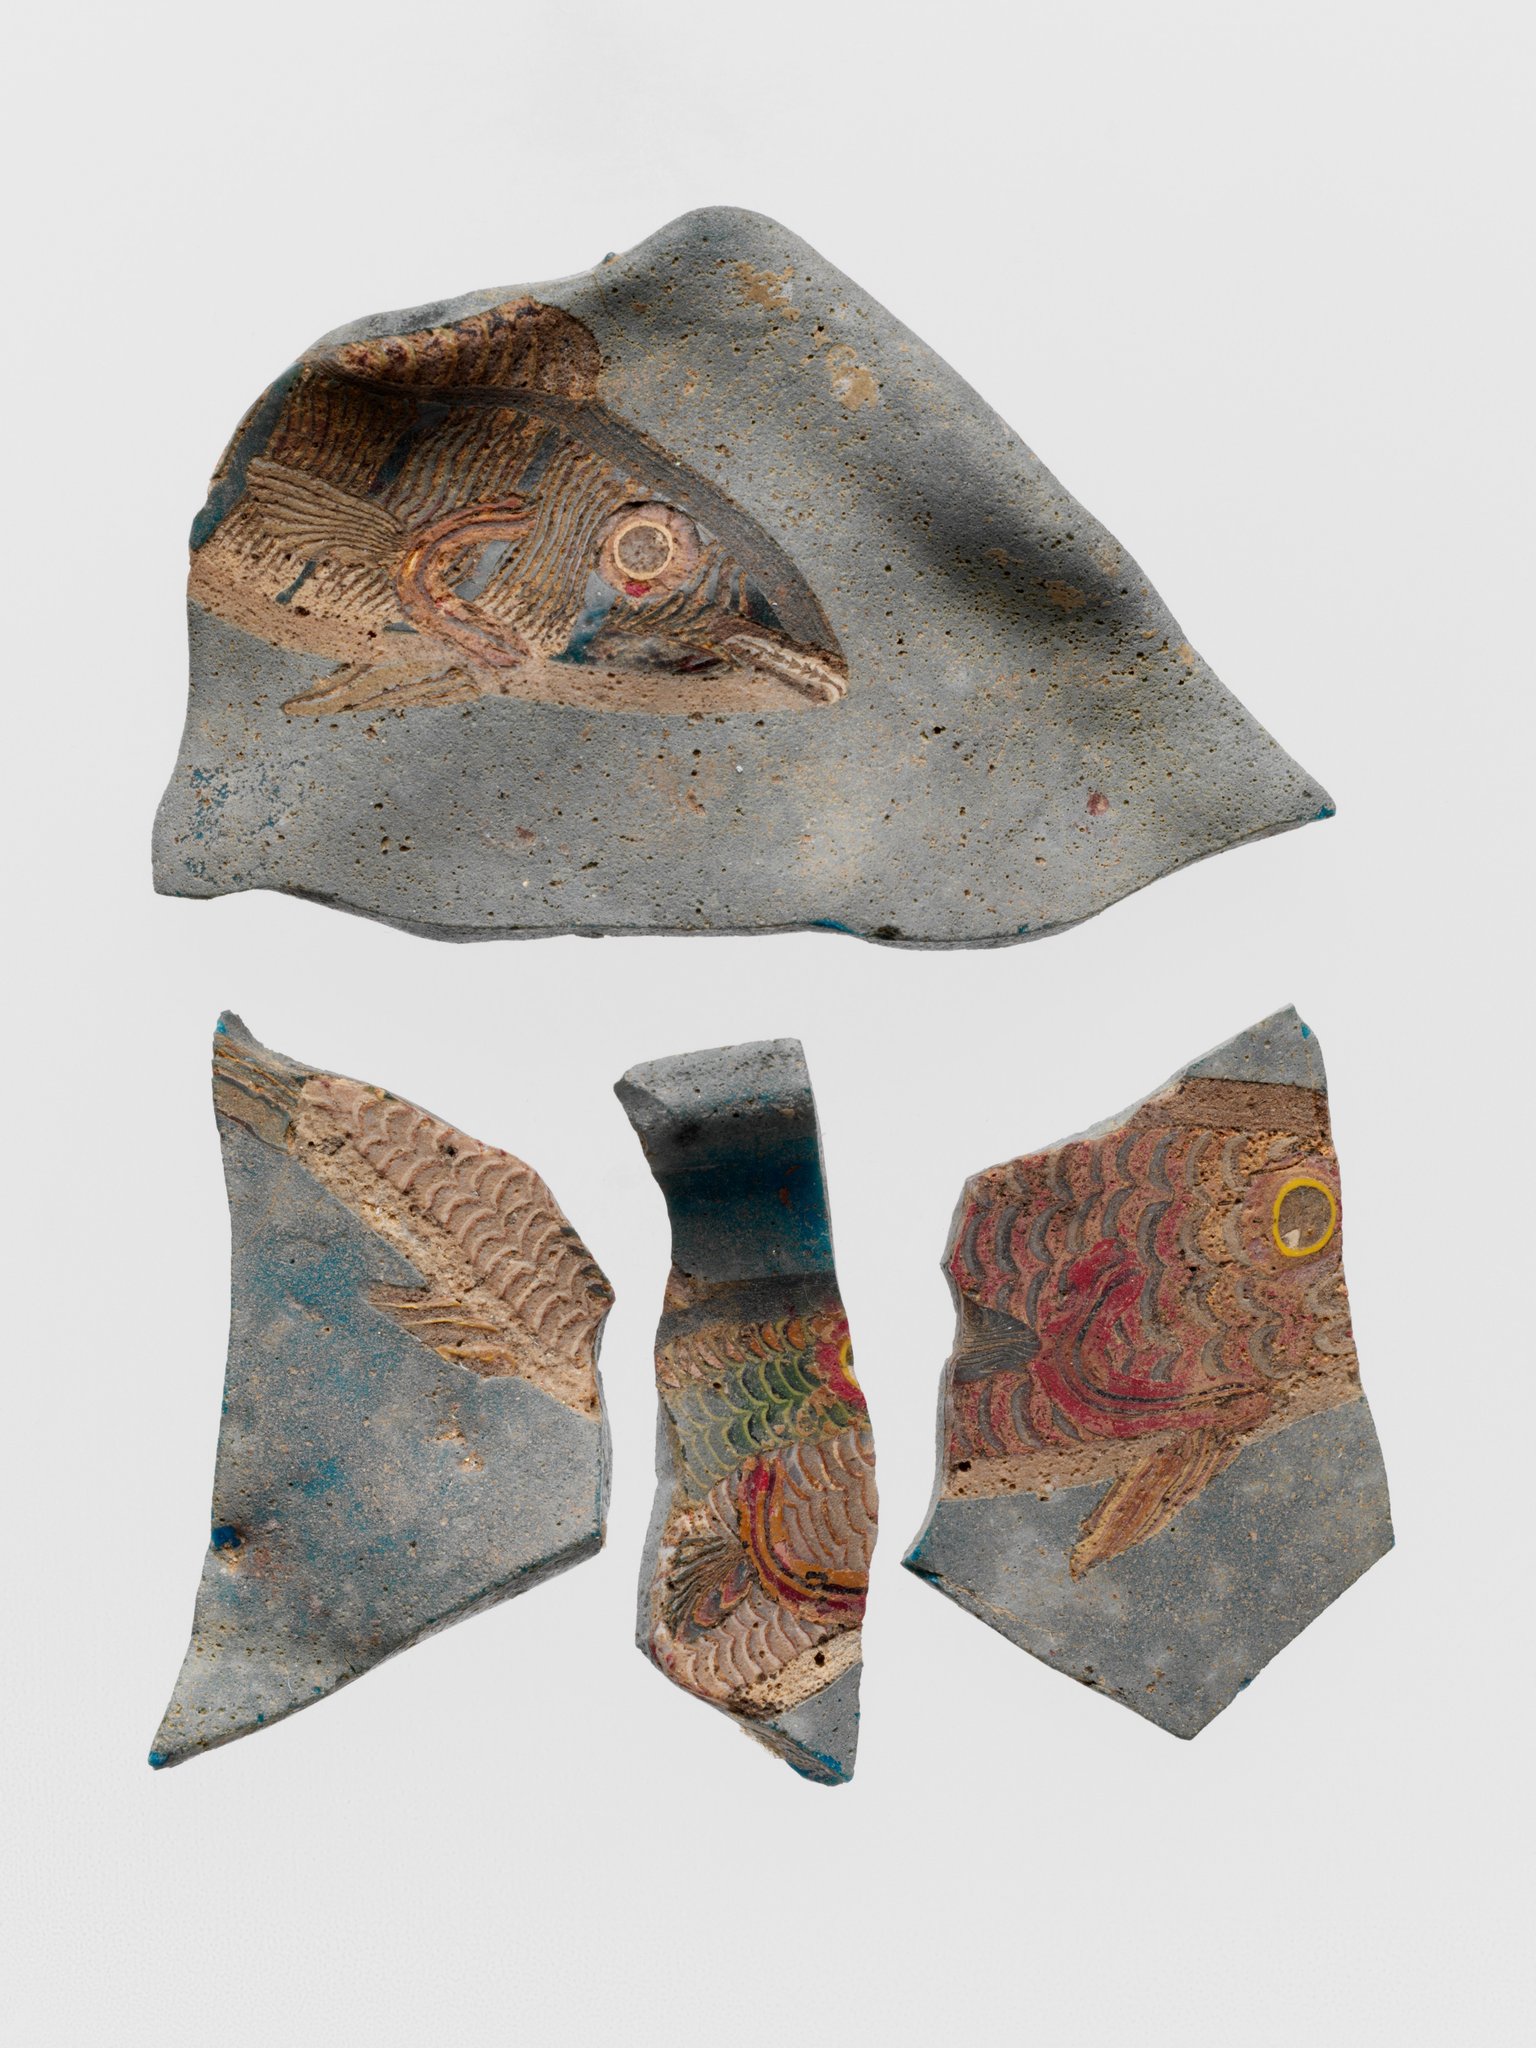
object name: dish or plaque fragment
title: Glass fragments of bowl decorated with mosaic fish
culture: roman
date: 1-300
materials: glass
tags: fish